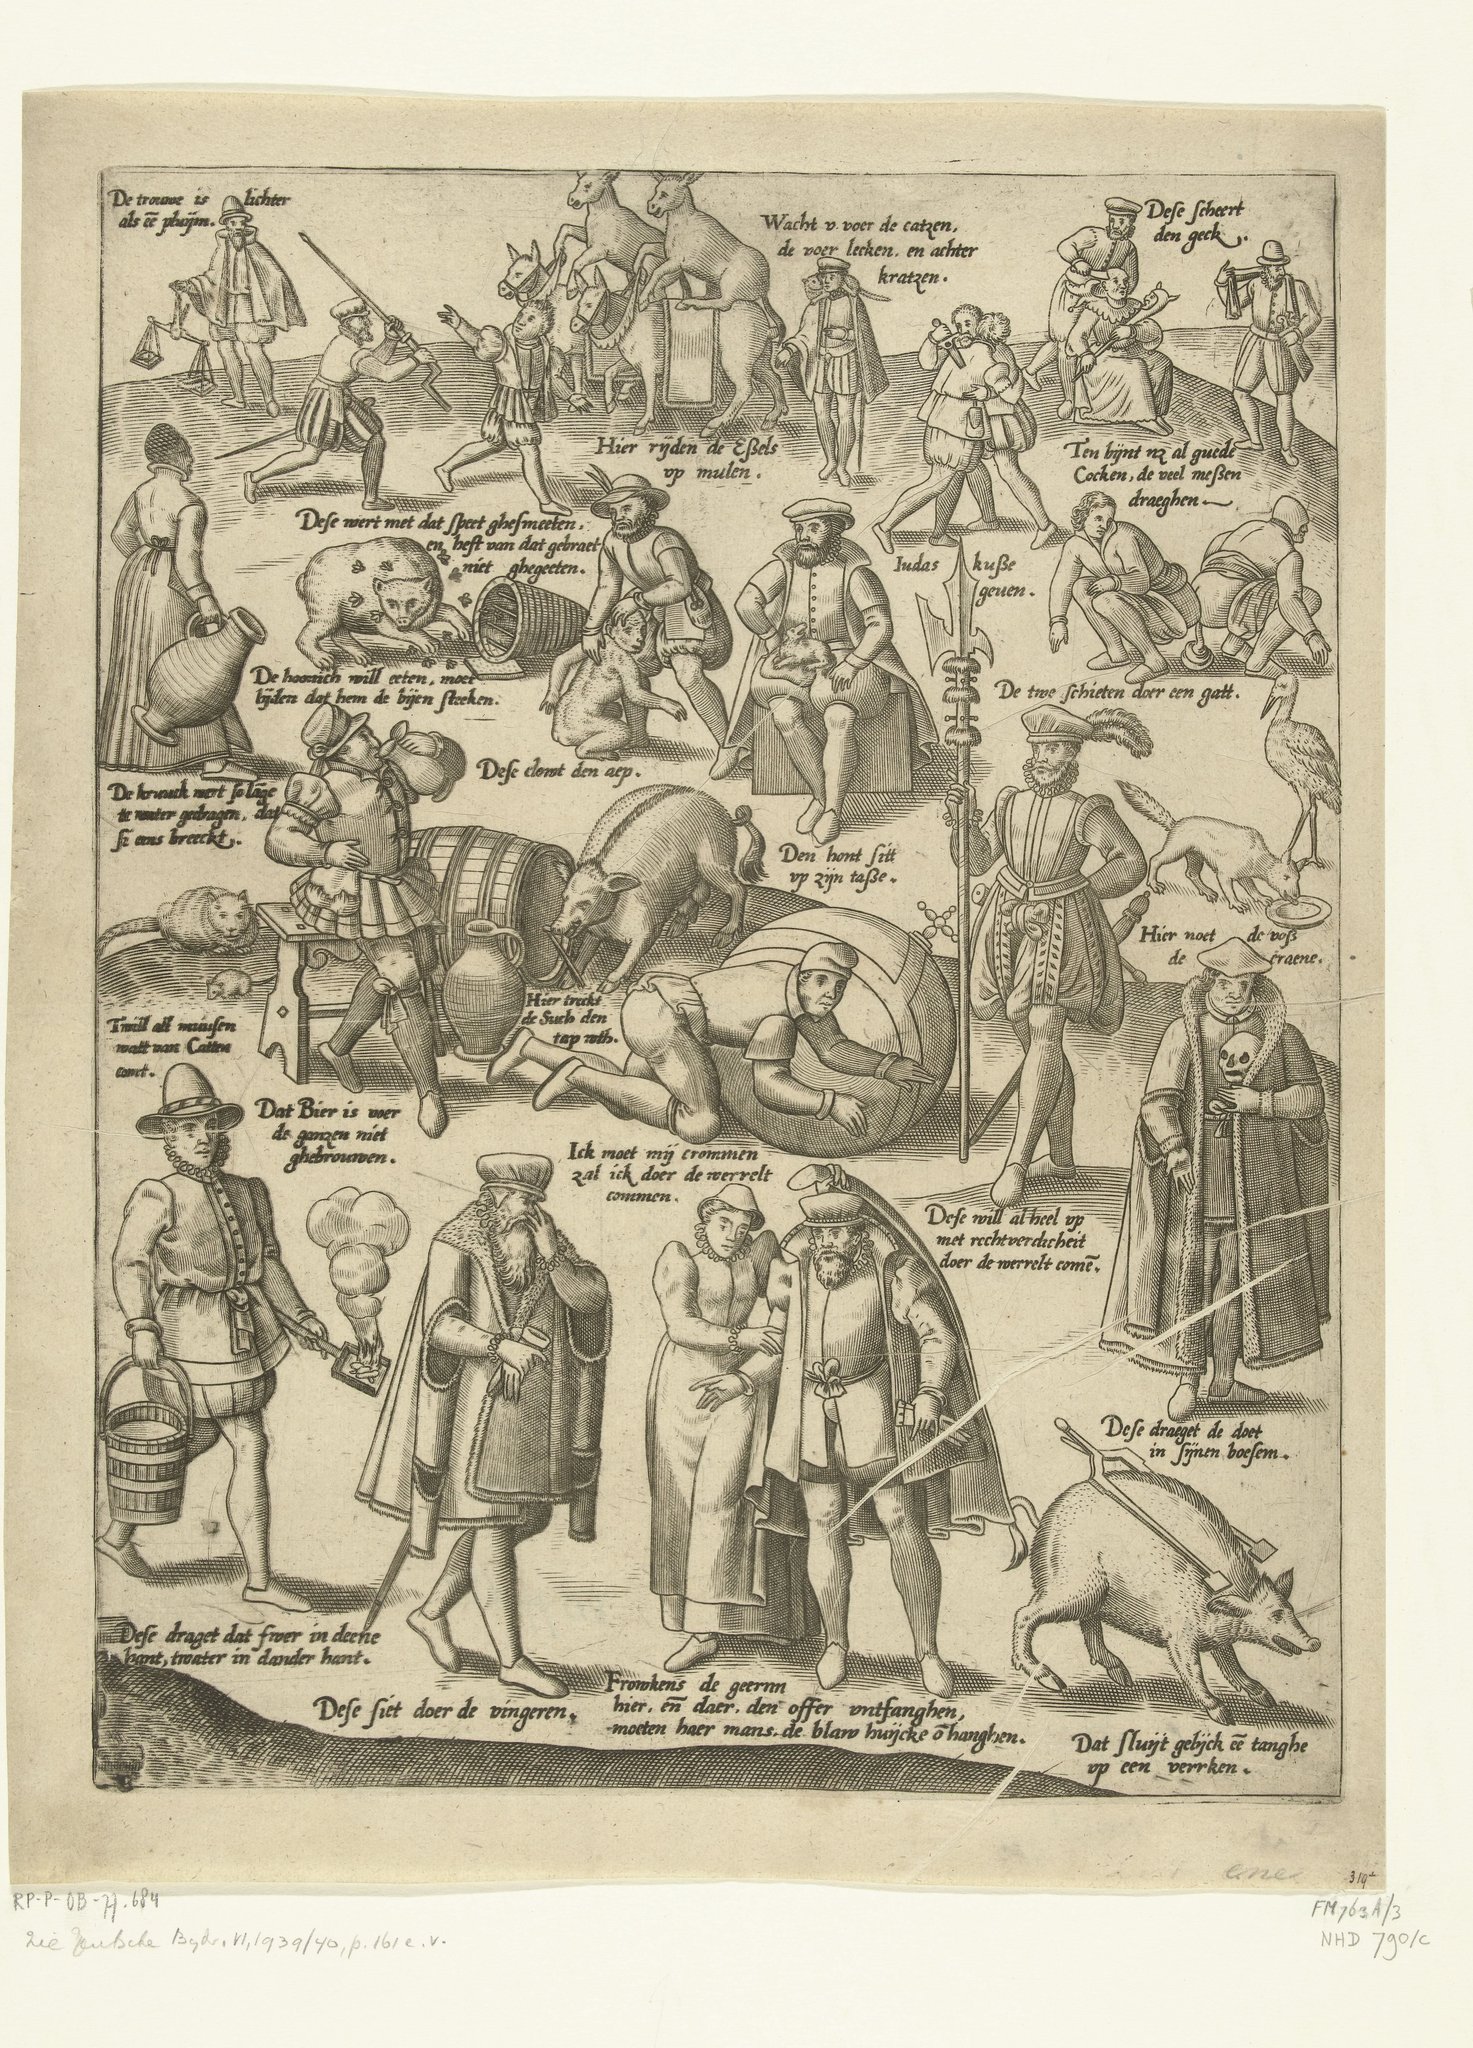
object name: print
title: De Blauwe Huyck (blad 3)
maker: joannes van doetechum (i)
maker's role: print maker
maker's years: 1528-1605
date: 1577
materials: paper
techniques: engraving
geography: low countries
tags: proverbs, sayings, etc.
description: De Blauwe Huyck (blad 3). Verschillende spreekwoorden op een blad: l.o.: dese siet doer de vingeren / r.o.: dat sluijt gelijck ee[n] tanghe op een verrken / r.b.: dese scheert den geck / m.b.: wacht u voer de catzen, die voer lecken, en achter kratzen.